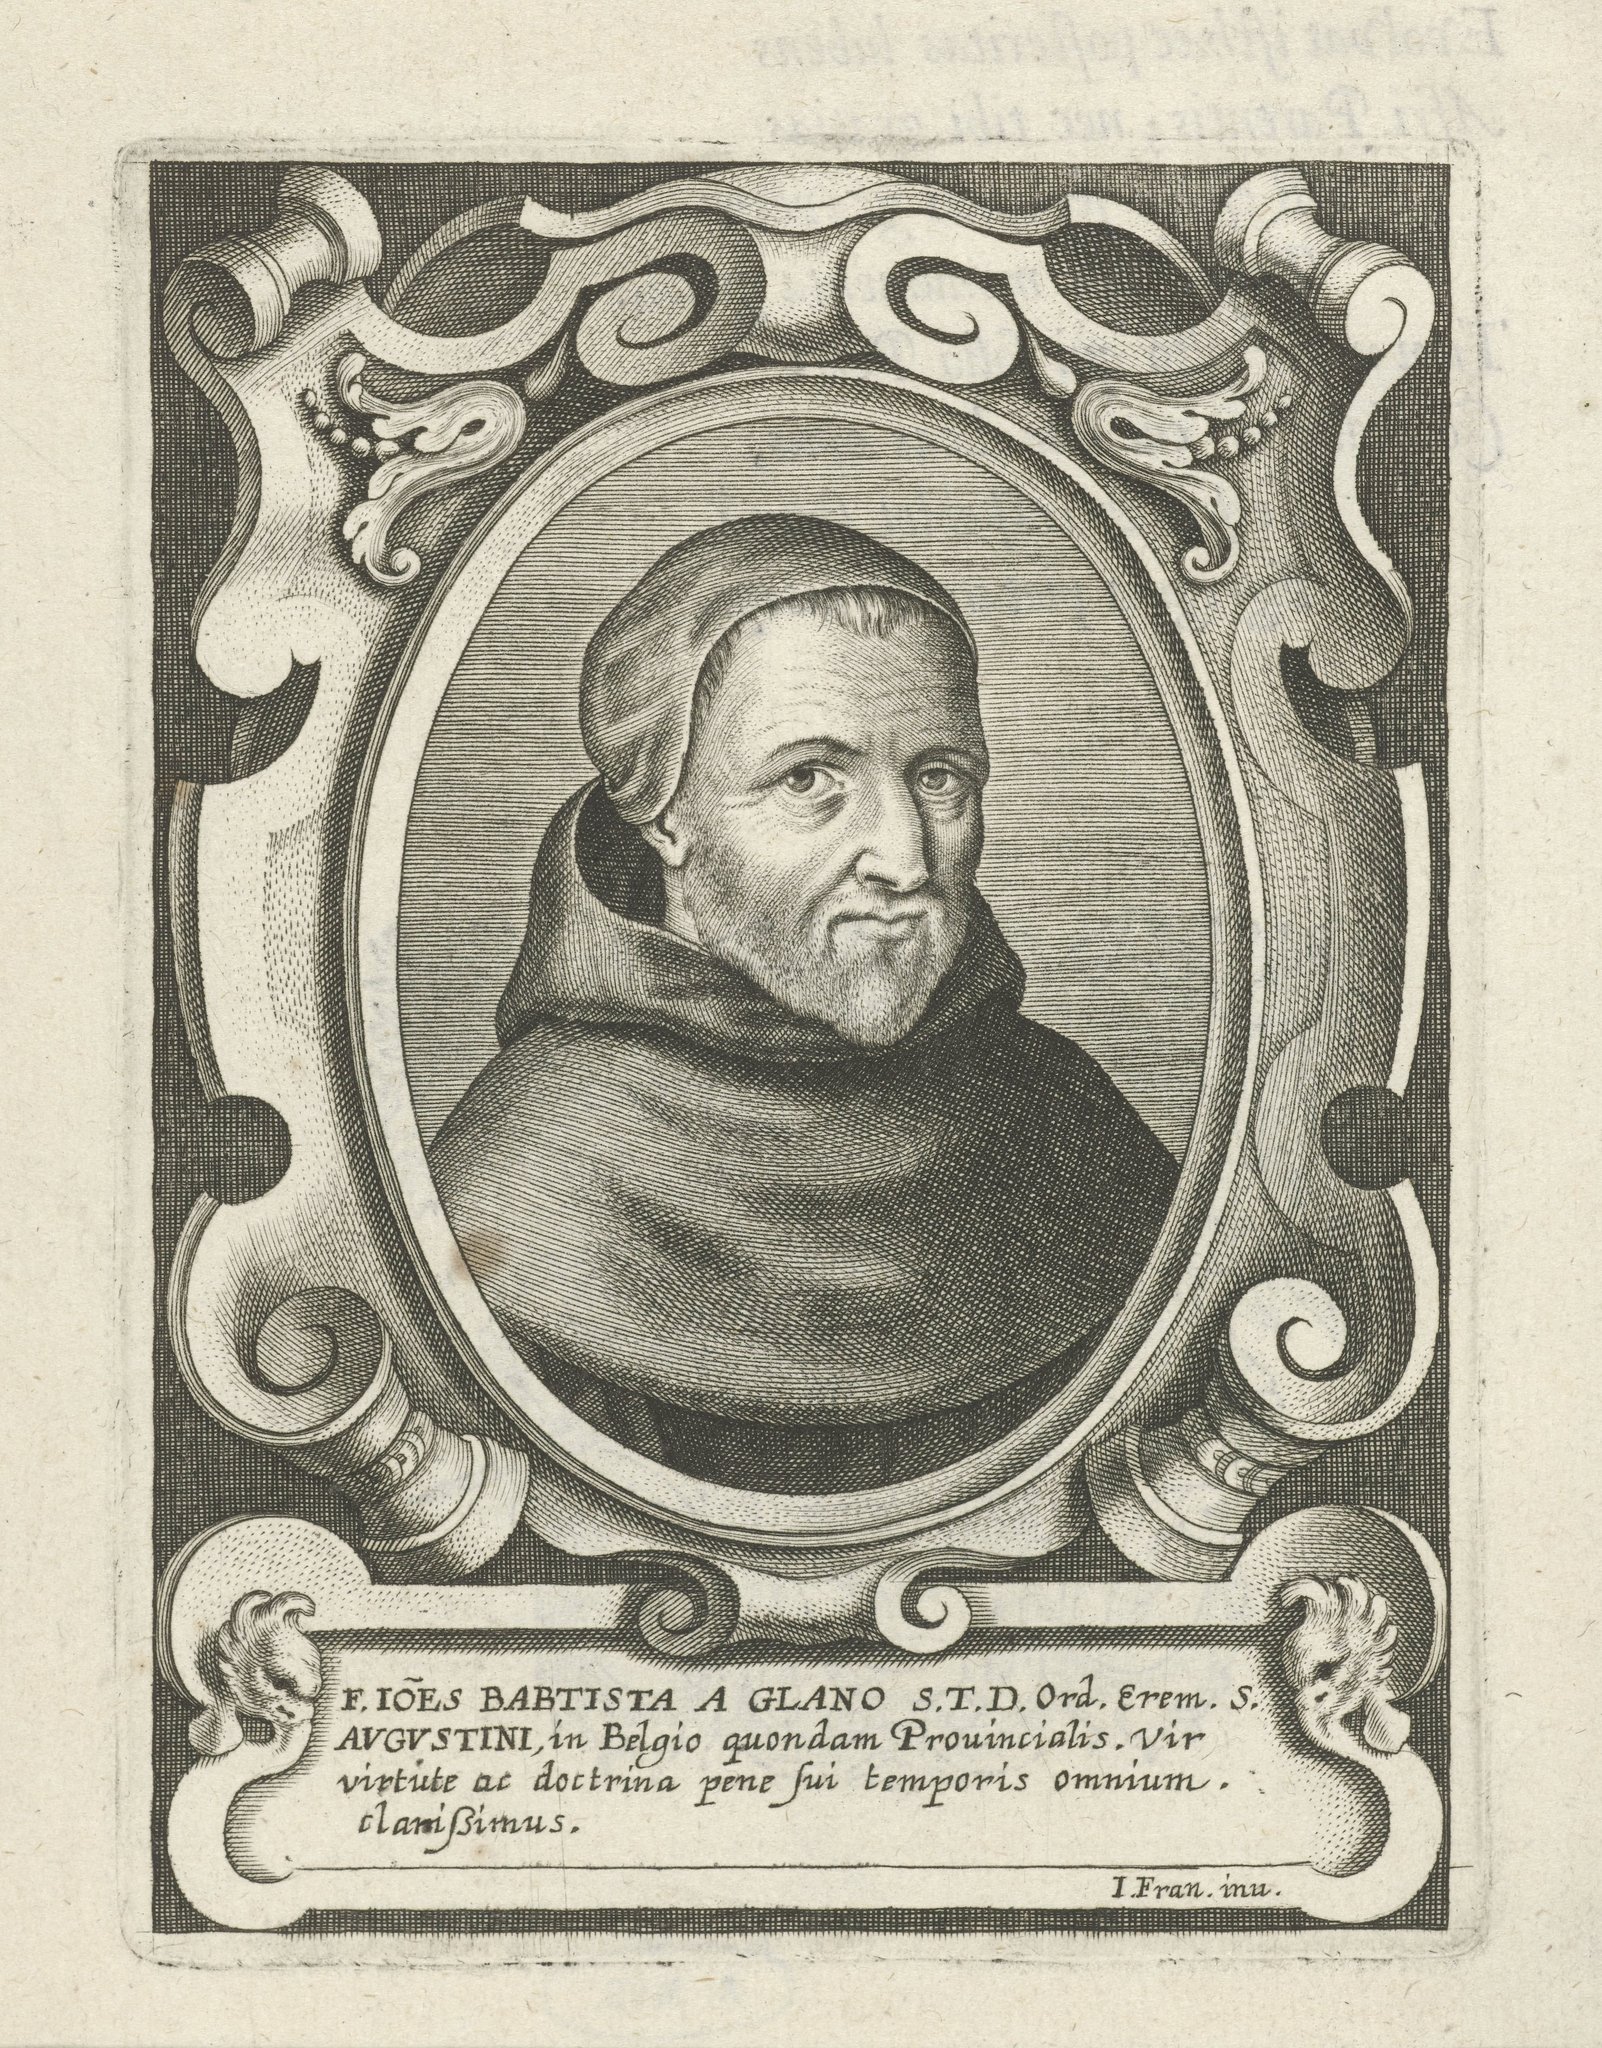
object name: print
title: Portret van de Augustijn Joannes Baptista a Glano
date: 1636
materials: paper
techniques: engraving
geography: southern netherlands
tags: monastic orders, monastic life ~ roman catholic church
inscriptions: collector's mark: Lugt 2228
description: Boekillustratie voor: C. Curtius, Virorum illustrium ex ordine Eremitarum D. Augustini elogia , Antwerpen: J. Cnobbaert, 1636.